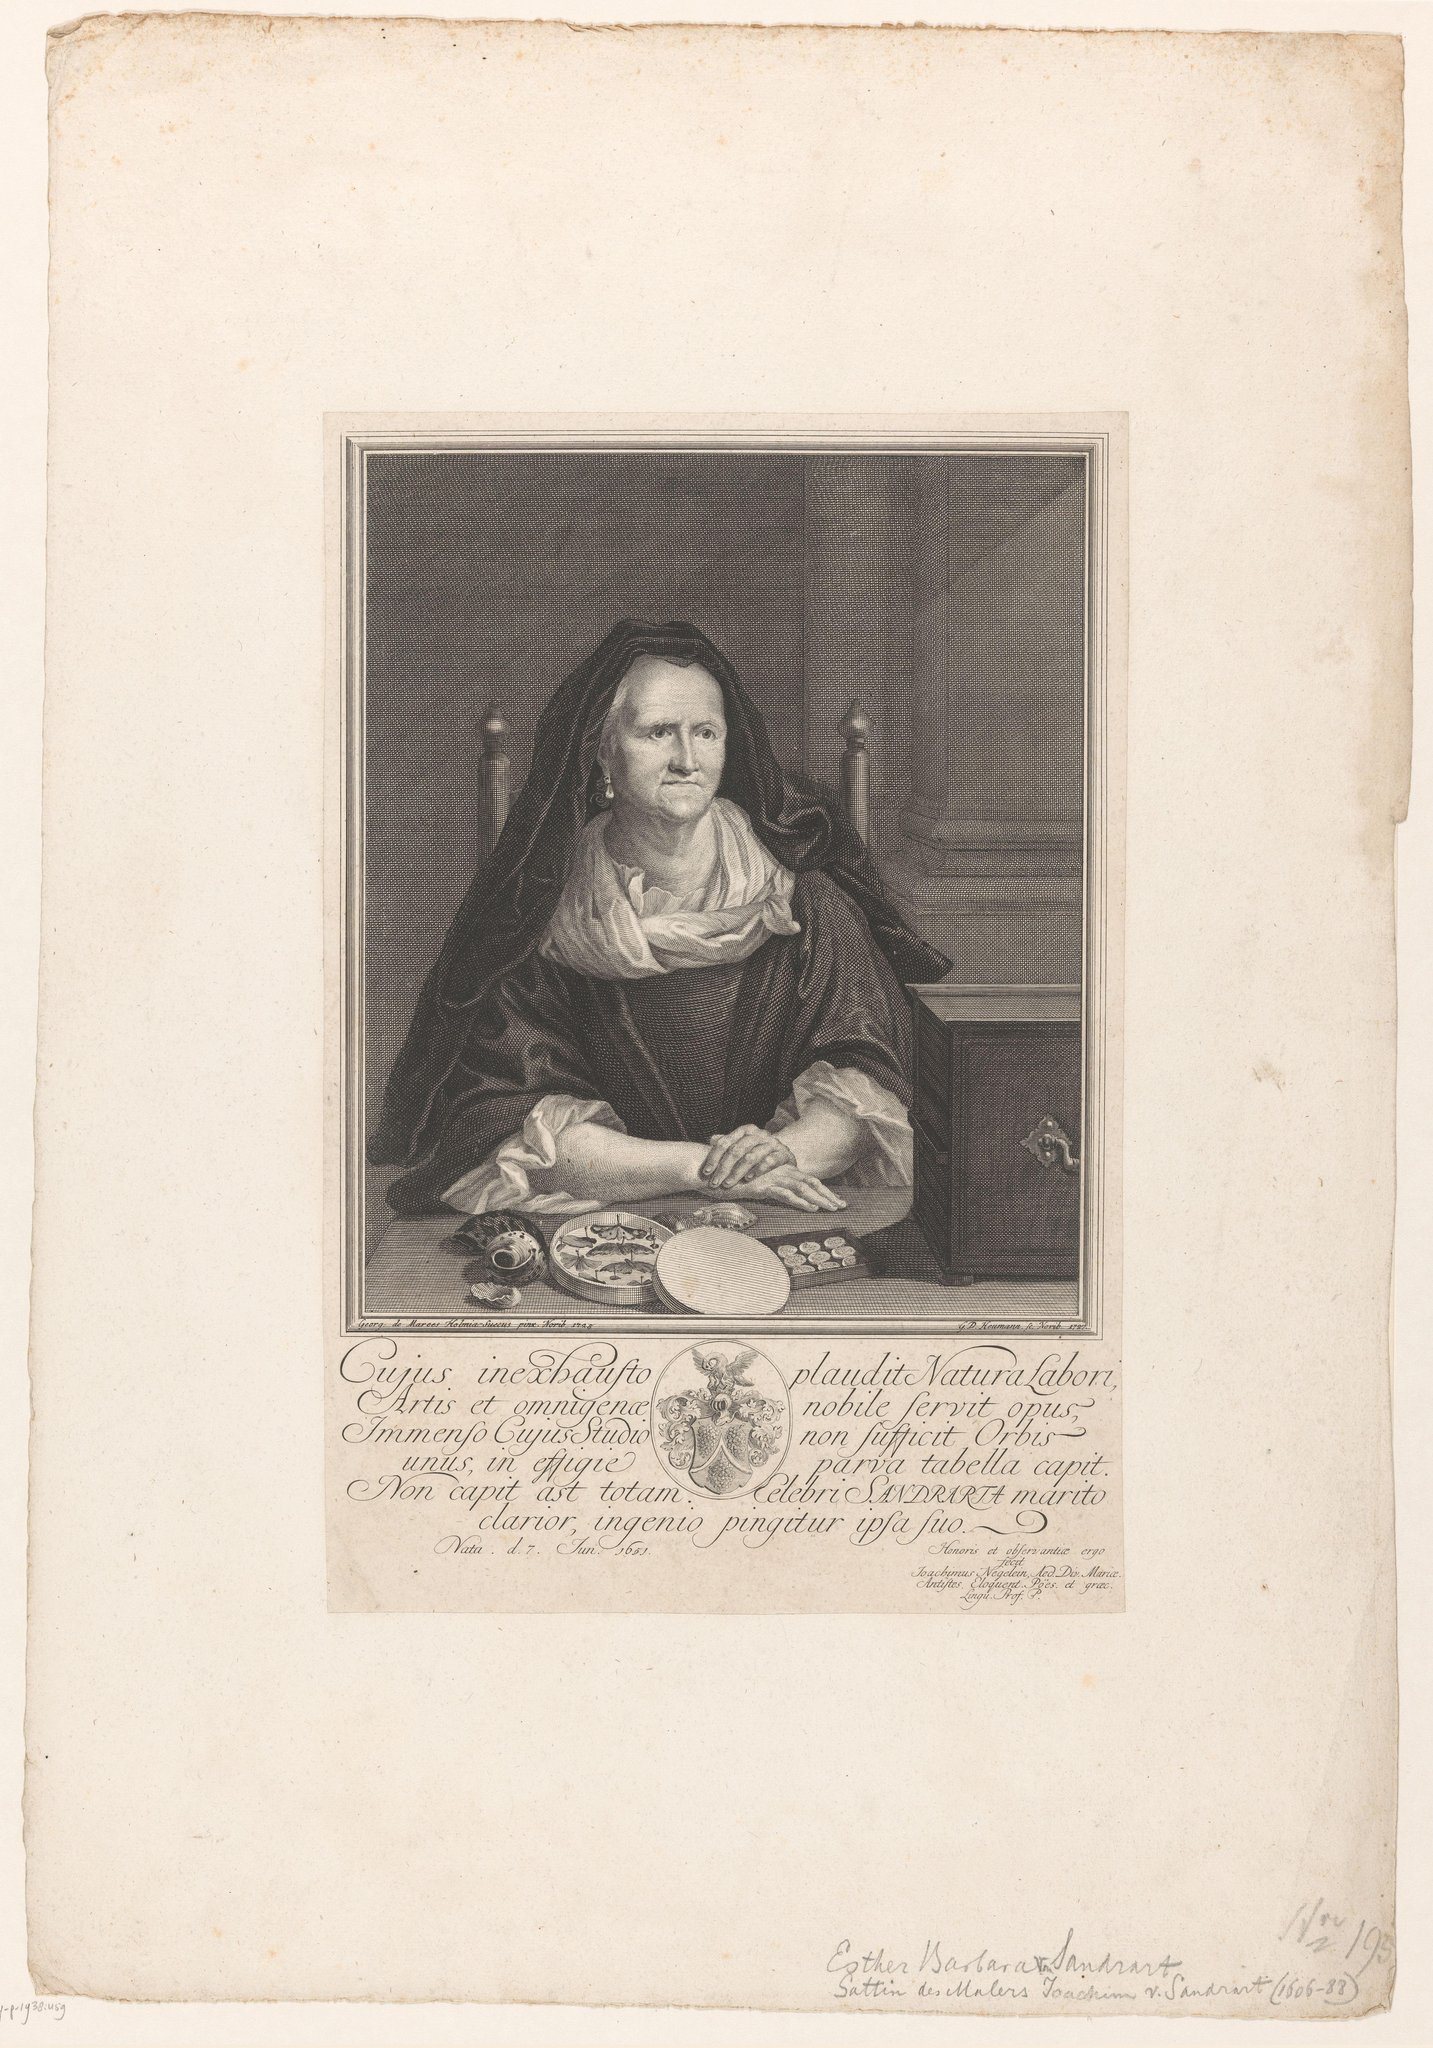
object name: print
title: Portret van Esther Barbara von Sandrart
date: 1727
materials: paper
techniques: engraving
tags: historical persons - bb - woman, molluscs, coin, cabinet of curiosities, 'kunst- und wunderkammer', insects: butterfly, armorial bearing, heraldry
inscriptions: collector's mark: Lugt 2228